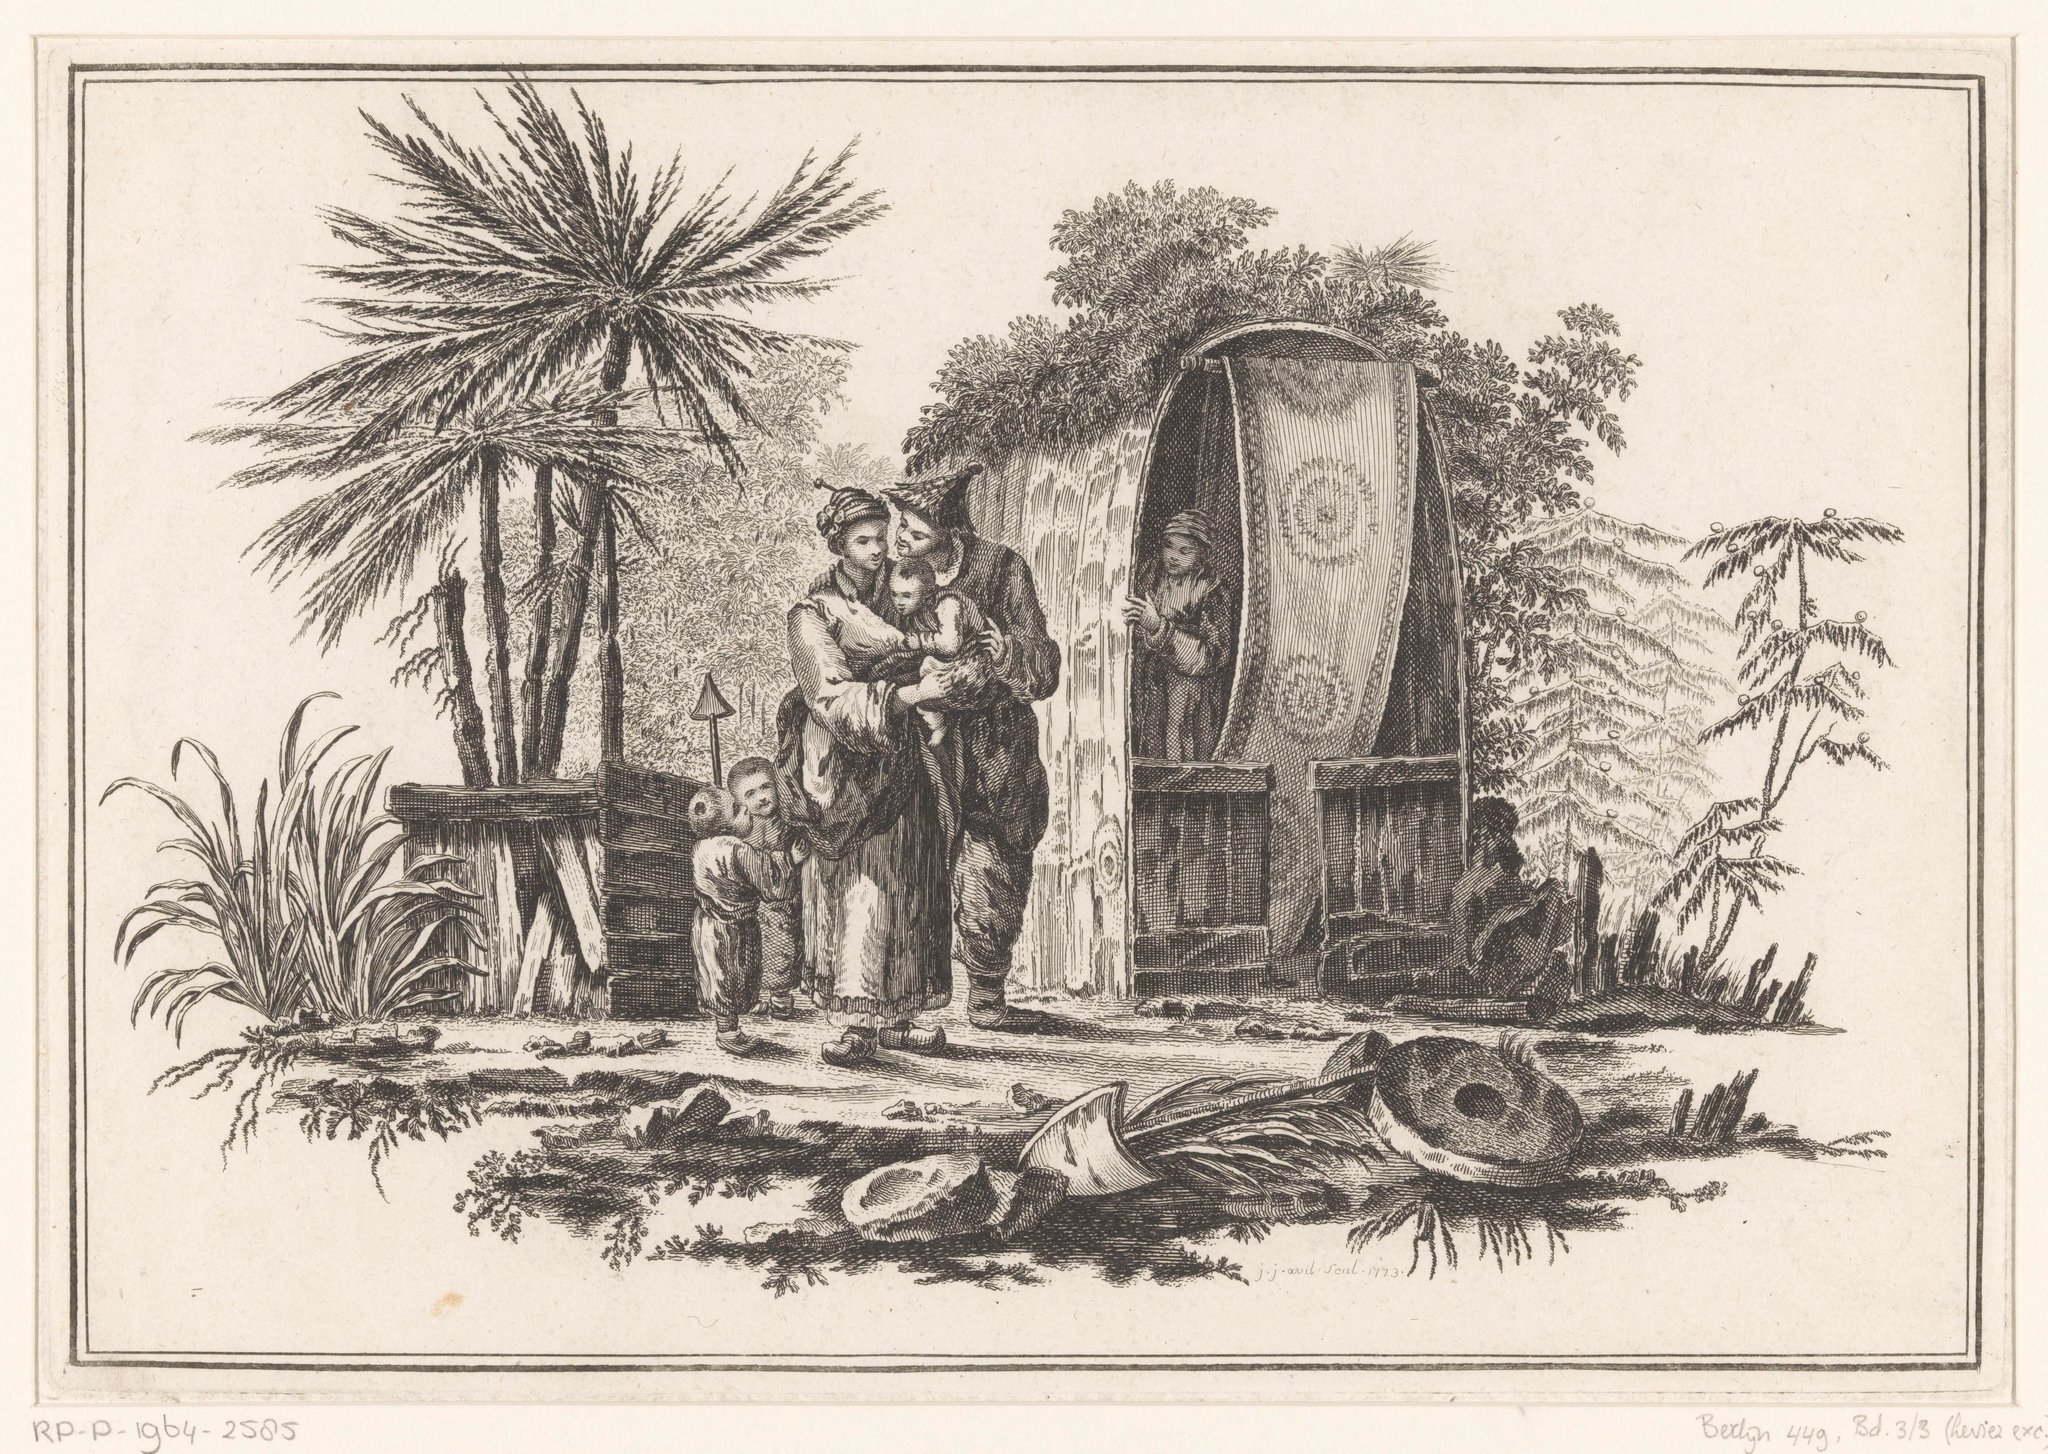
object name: print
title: Nouveau Cahier de Six Feuilles De Différents Sujets Chinois Historiés, Représentant les Cinq Sens de Natures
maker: jean jacques avril (i)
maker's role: print maker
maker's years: 1744-1831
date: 1773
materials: paper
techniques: etching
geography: paris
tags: feeling (one of the five senses)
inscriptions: collector's mark: Lugt 2760, collector's mark: Lugt 2228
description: Personificatie van het zintuig de tast. In een landschap staan een man en vrouw met een kind. Links staan nog twee kinderen. Rechts vanuit een houten overkapping kijkt een man toe.